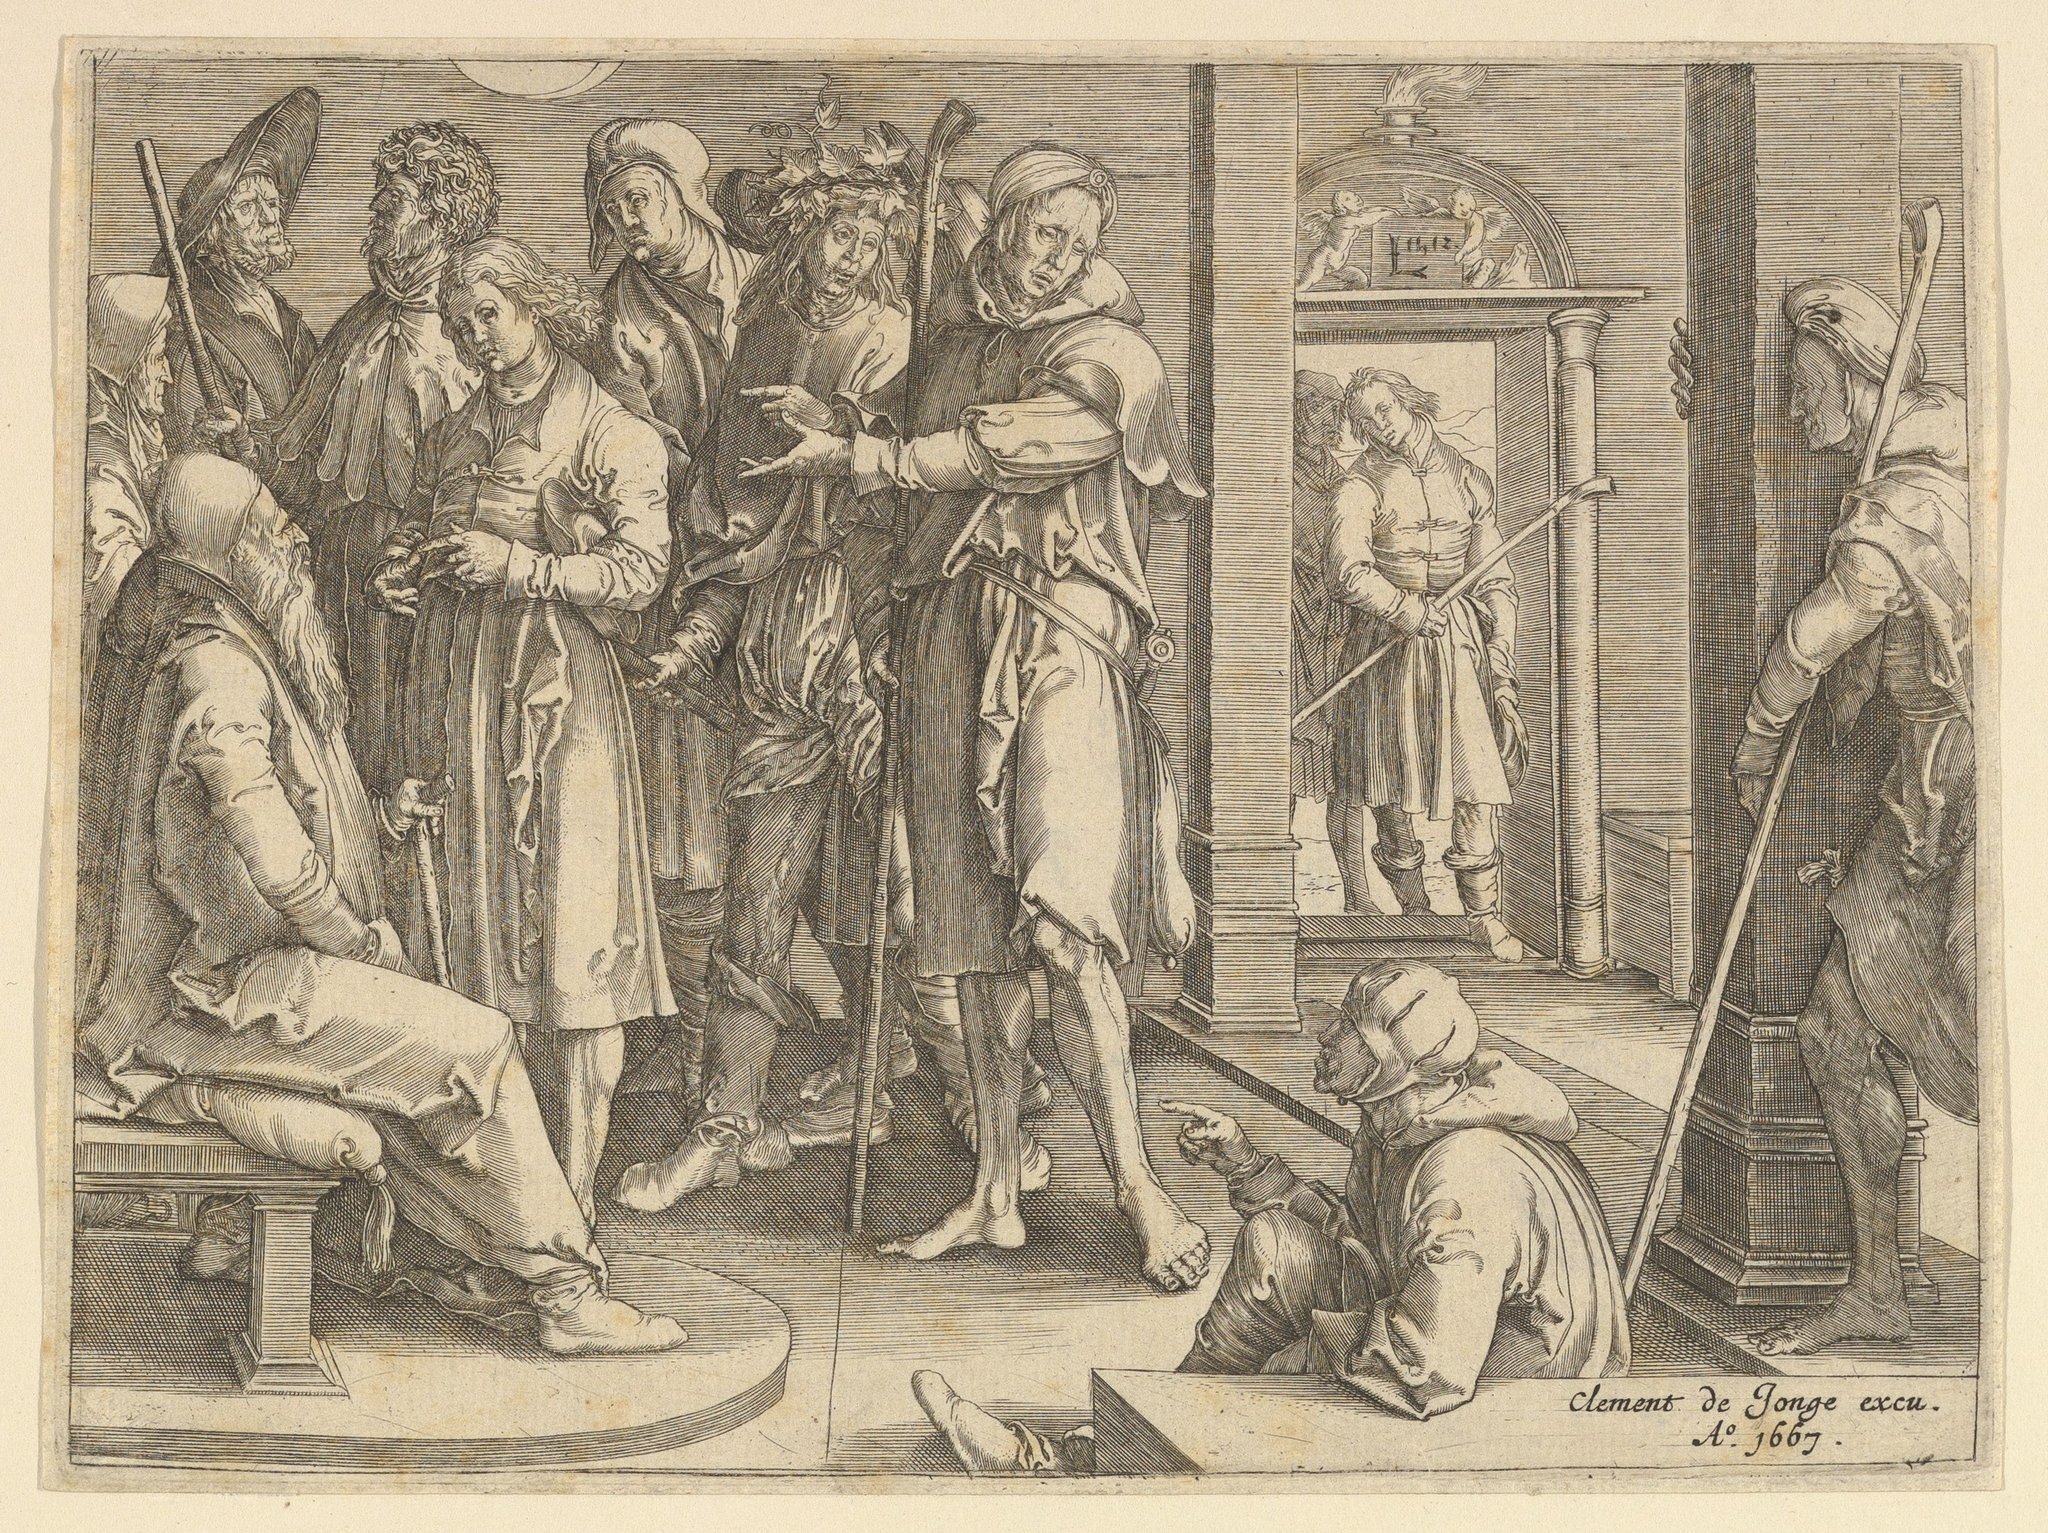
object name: print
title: Joseph Telling His Dreams to Jacob (copy)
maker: clement de jonghe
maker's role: publisher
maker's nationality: dutch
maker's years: 1624-1670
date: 1640-1670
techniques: engraving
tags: men,women